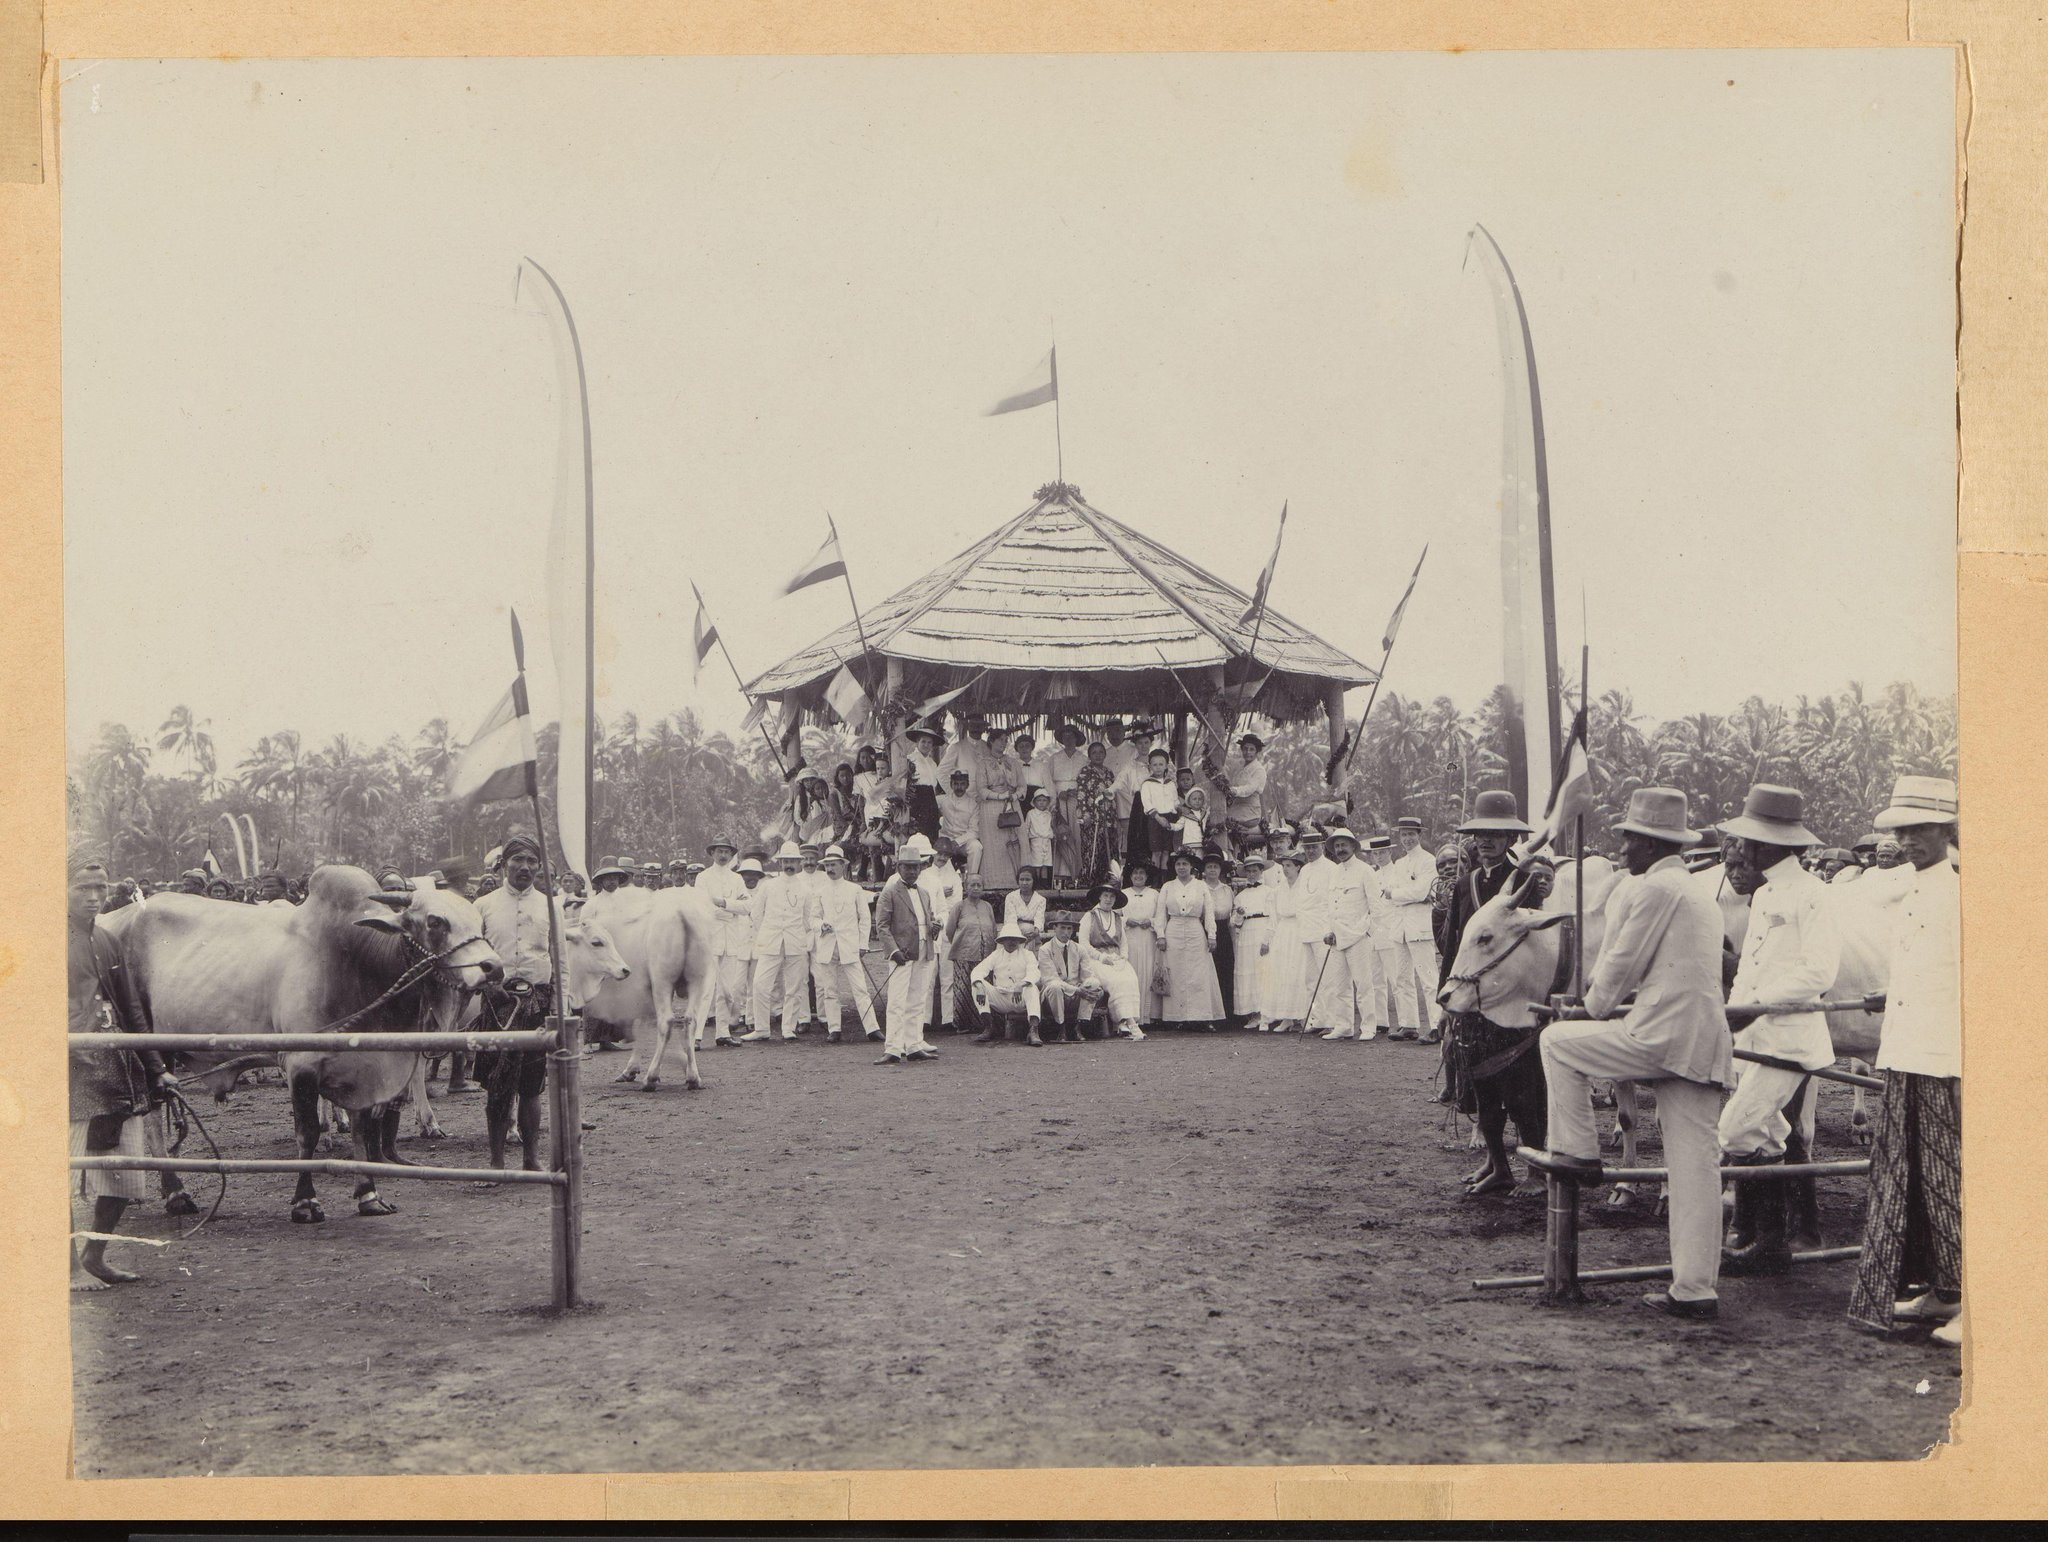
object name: photograph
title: Indonesiërs en Europeanen en buffels bij onbekend evenement in Nederlands-Indië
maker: Anonymous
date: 1916-1918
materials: photographic support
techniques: gelatin silver print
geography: dutch east indies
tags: cattle, festivities, dutch east indies, the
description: Onderdeel van Familiealbum met foto's van een familie in de voormalige kolonie Nederlands-Indië en van een suikerfabriek in Purworejo.